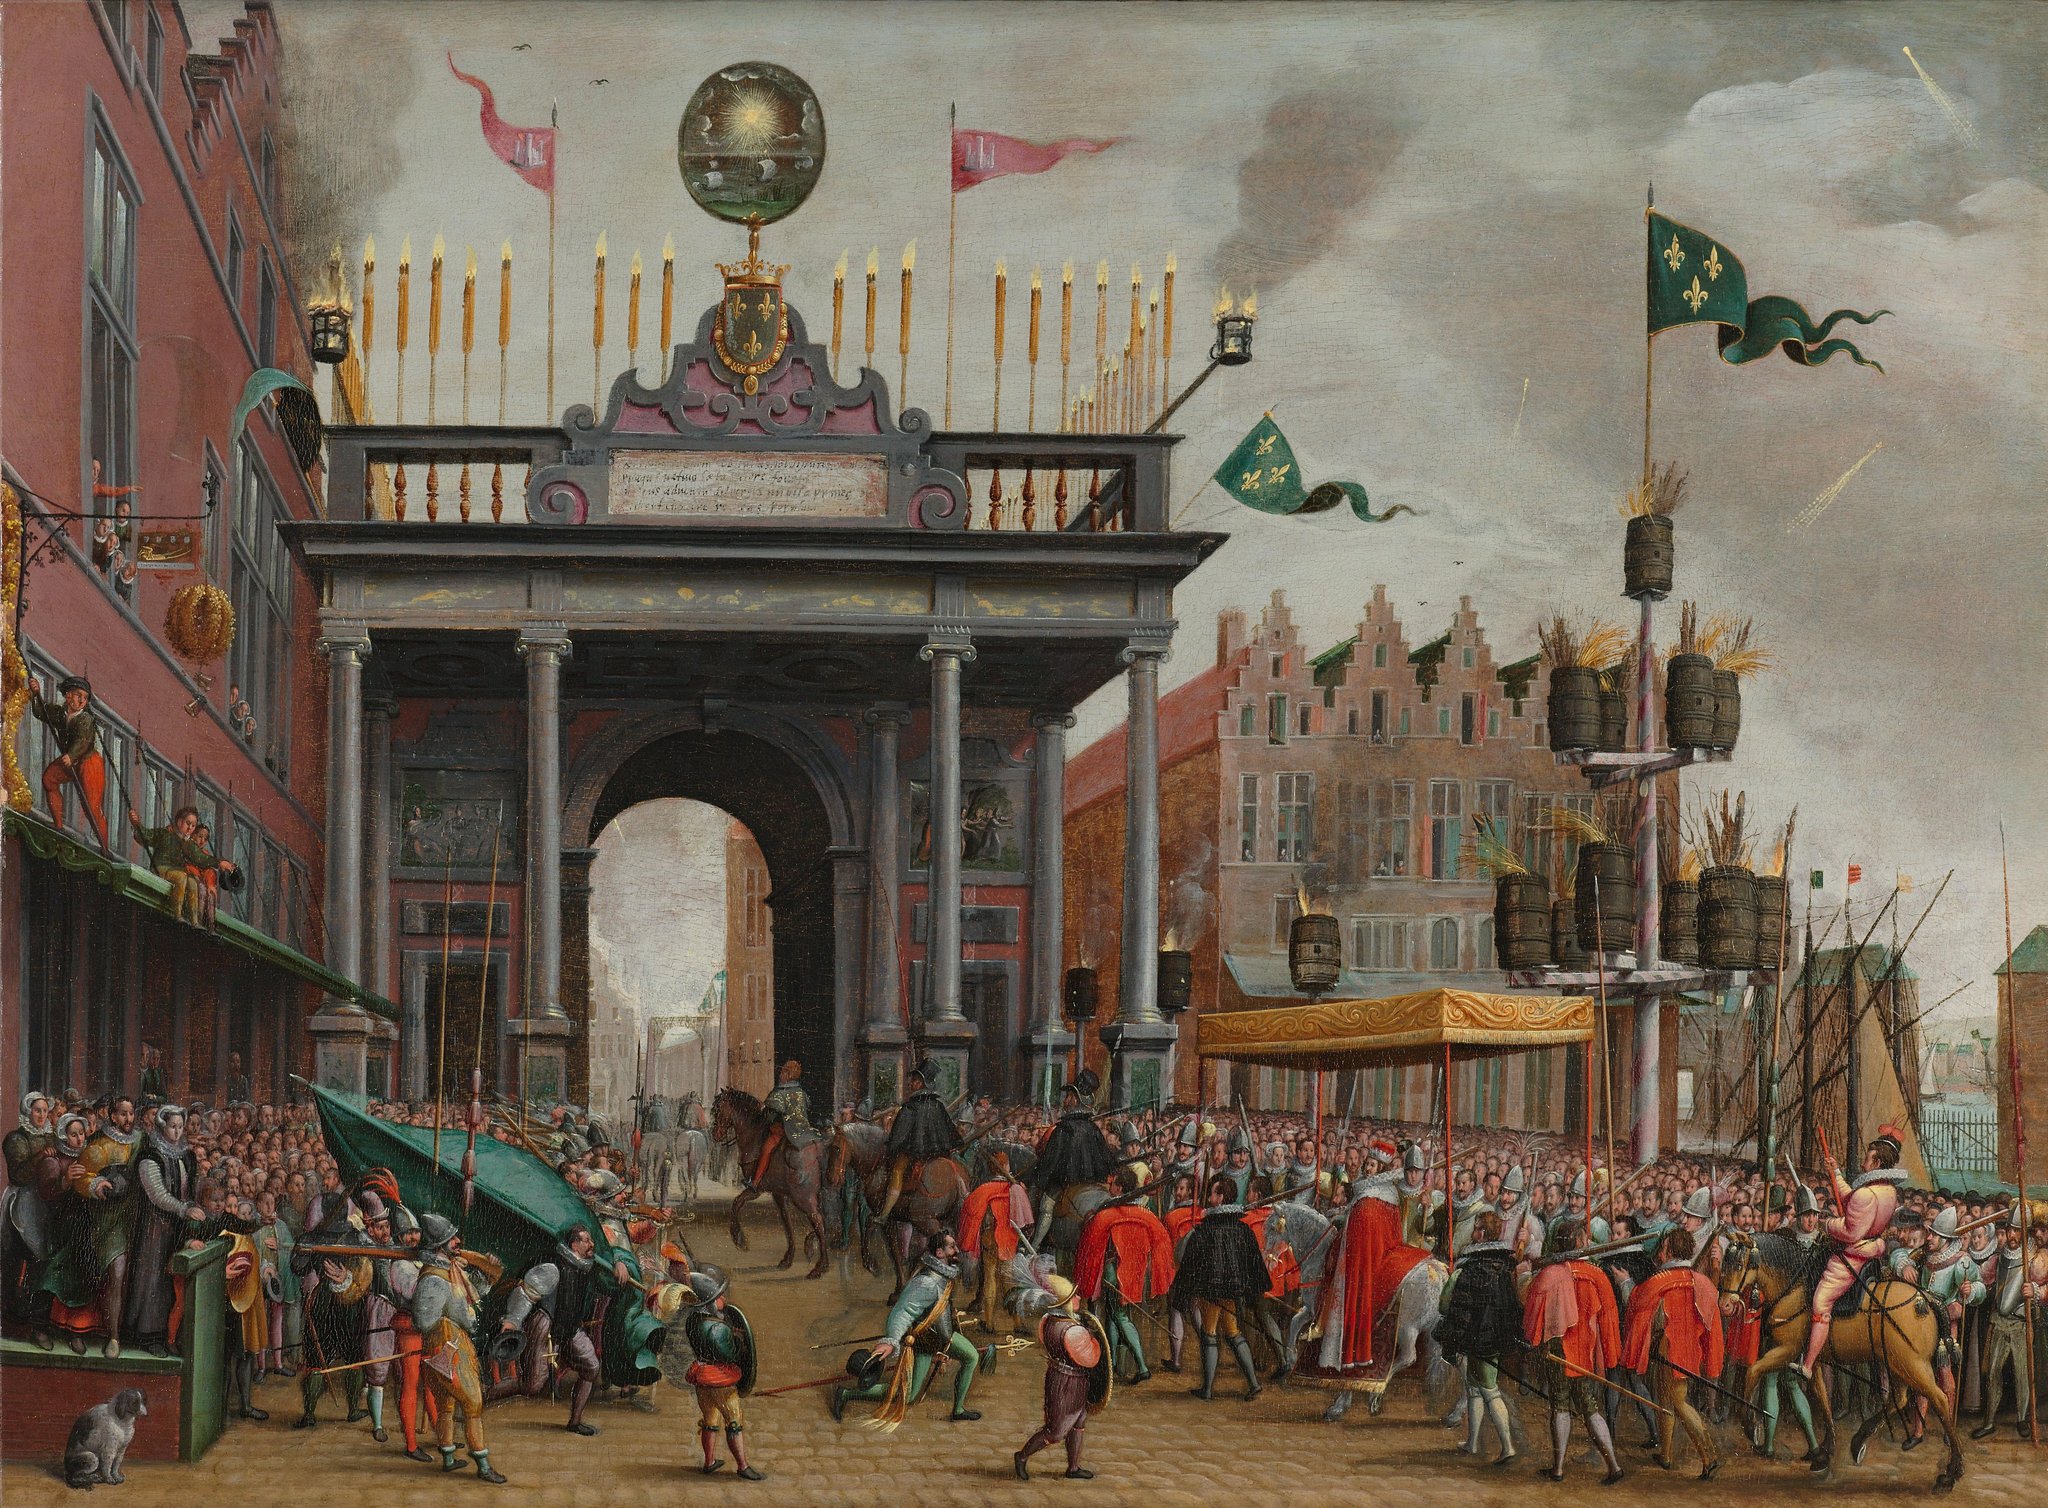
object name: painting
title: Joyful Entry of the Duke of Anjou in Antwerp on 19 February 1582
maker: monogrammist mhvh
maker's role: painter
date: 1582-1600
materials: oil, panel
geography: antwerp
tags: paris, françois-hercule de valois (hertog van anjou), triumphal arch, triumphal entry and public reception, pageant, 'entrée solennelle', 'joyeuse entrée', antwerp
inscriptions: signature: ‘MHVH’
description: When Philip II is no longer recognized as the Low Countries’ sovereign, a new ruler is needed. François, Duke of Anjou, and the brother of the French king, is willing to take on this task. He is officially installed in Antwerp at the beginning of 1582. Here he is shown riding under a baldachin, approaching a triumphal arch erected in his honour. He solemnly promises to uphold all of the laws, however his regime is doomed to fail.